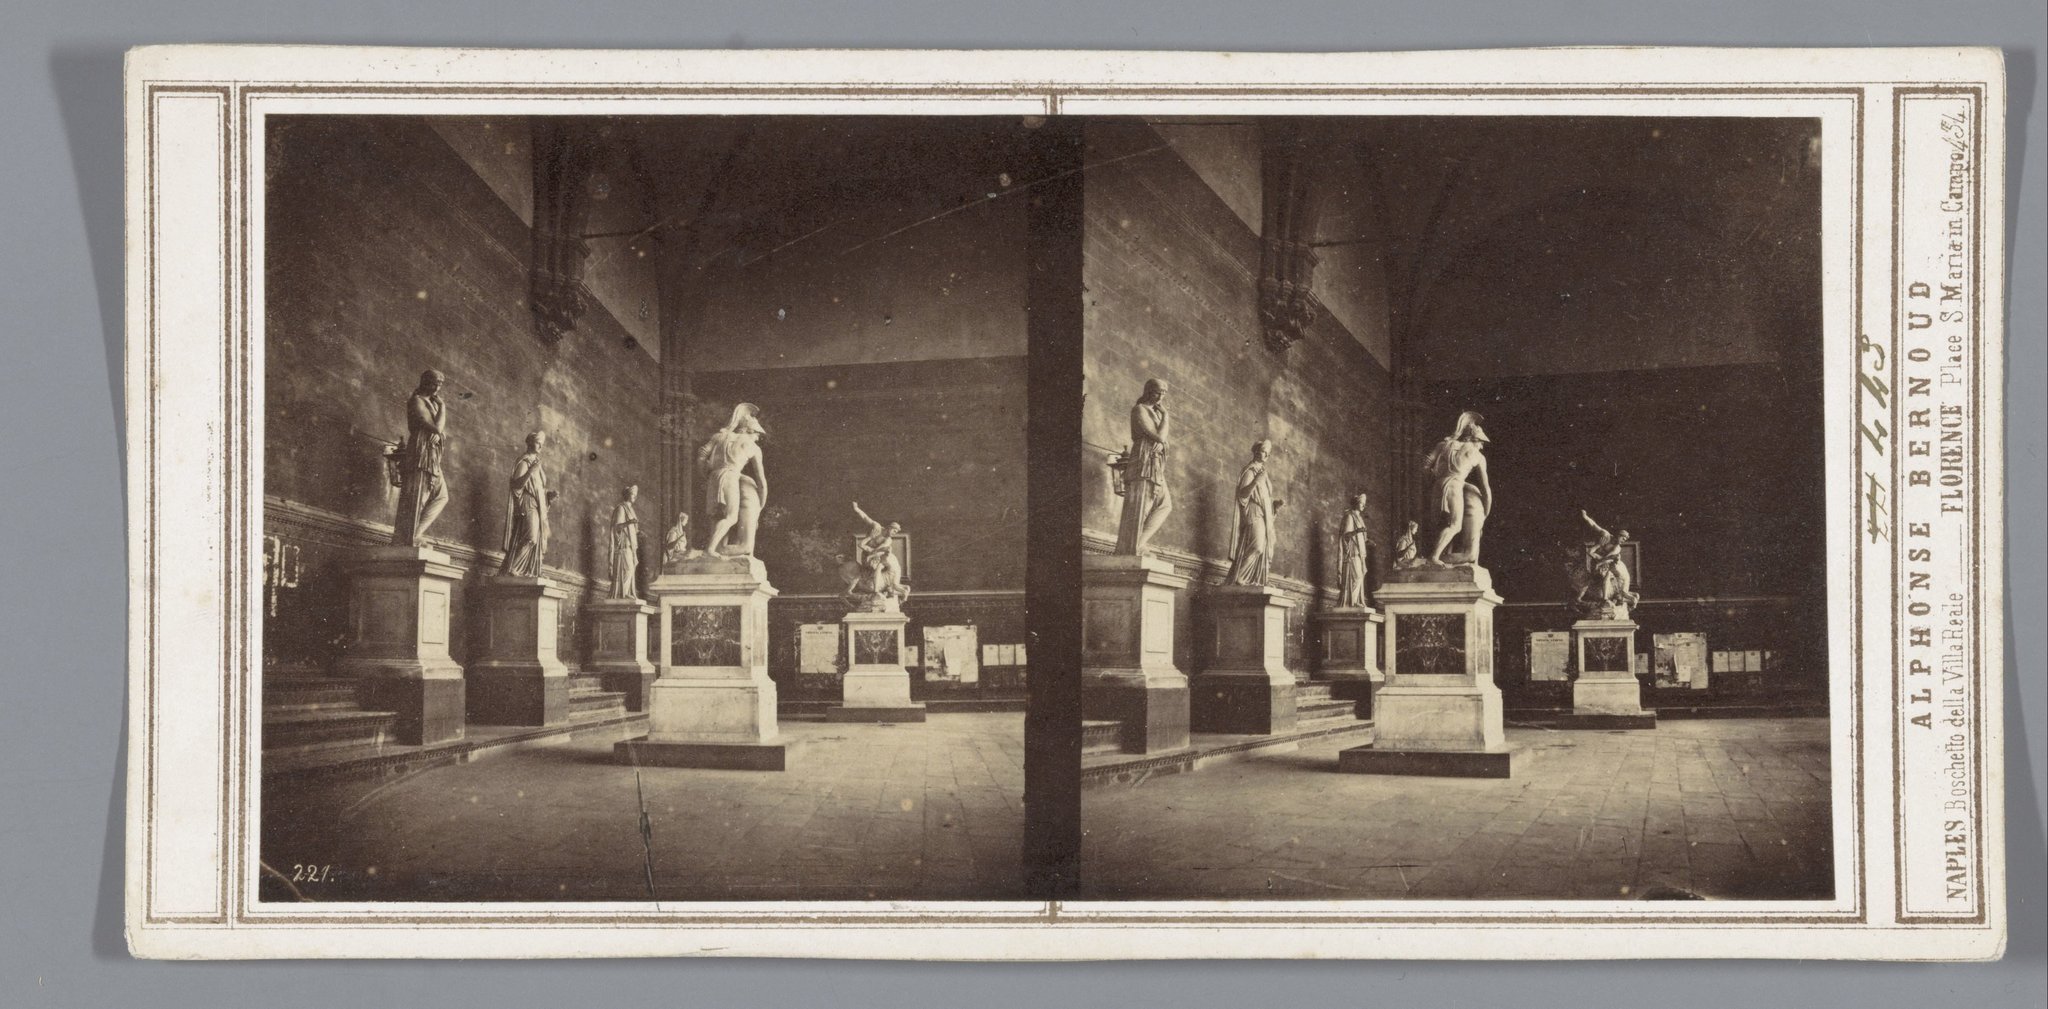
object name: stereograph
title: Sculpturen in de Loggia dei Lanzi te Florence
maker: alphonse bernoud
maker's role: fotograaf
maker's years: 1820-1889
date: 1850-1880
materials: cardboard, photographic support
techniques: albumen print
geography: loggia dei lanzi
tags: gallery of sculptures, sculpture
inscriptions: number: ‘221.’, inscription: ‘Interieur de la Loggia de Lanzi Florence’, name: ‘ALPHONSE BERNOUD NAPLES Boschetto della Villa Reale FLORENCE Place S. Maria in Campo 434.’